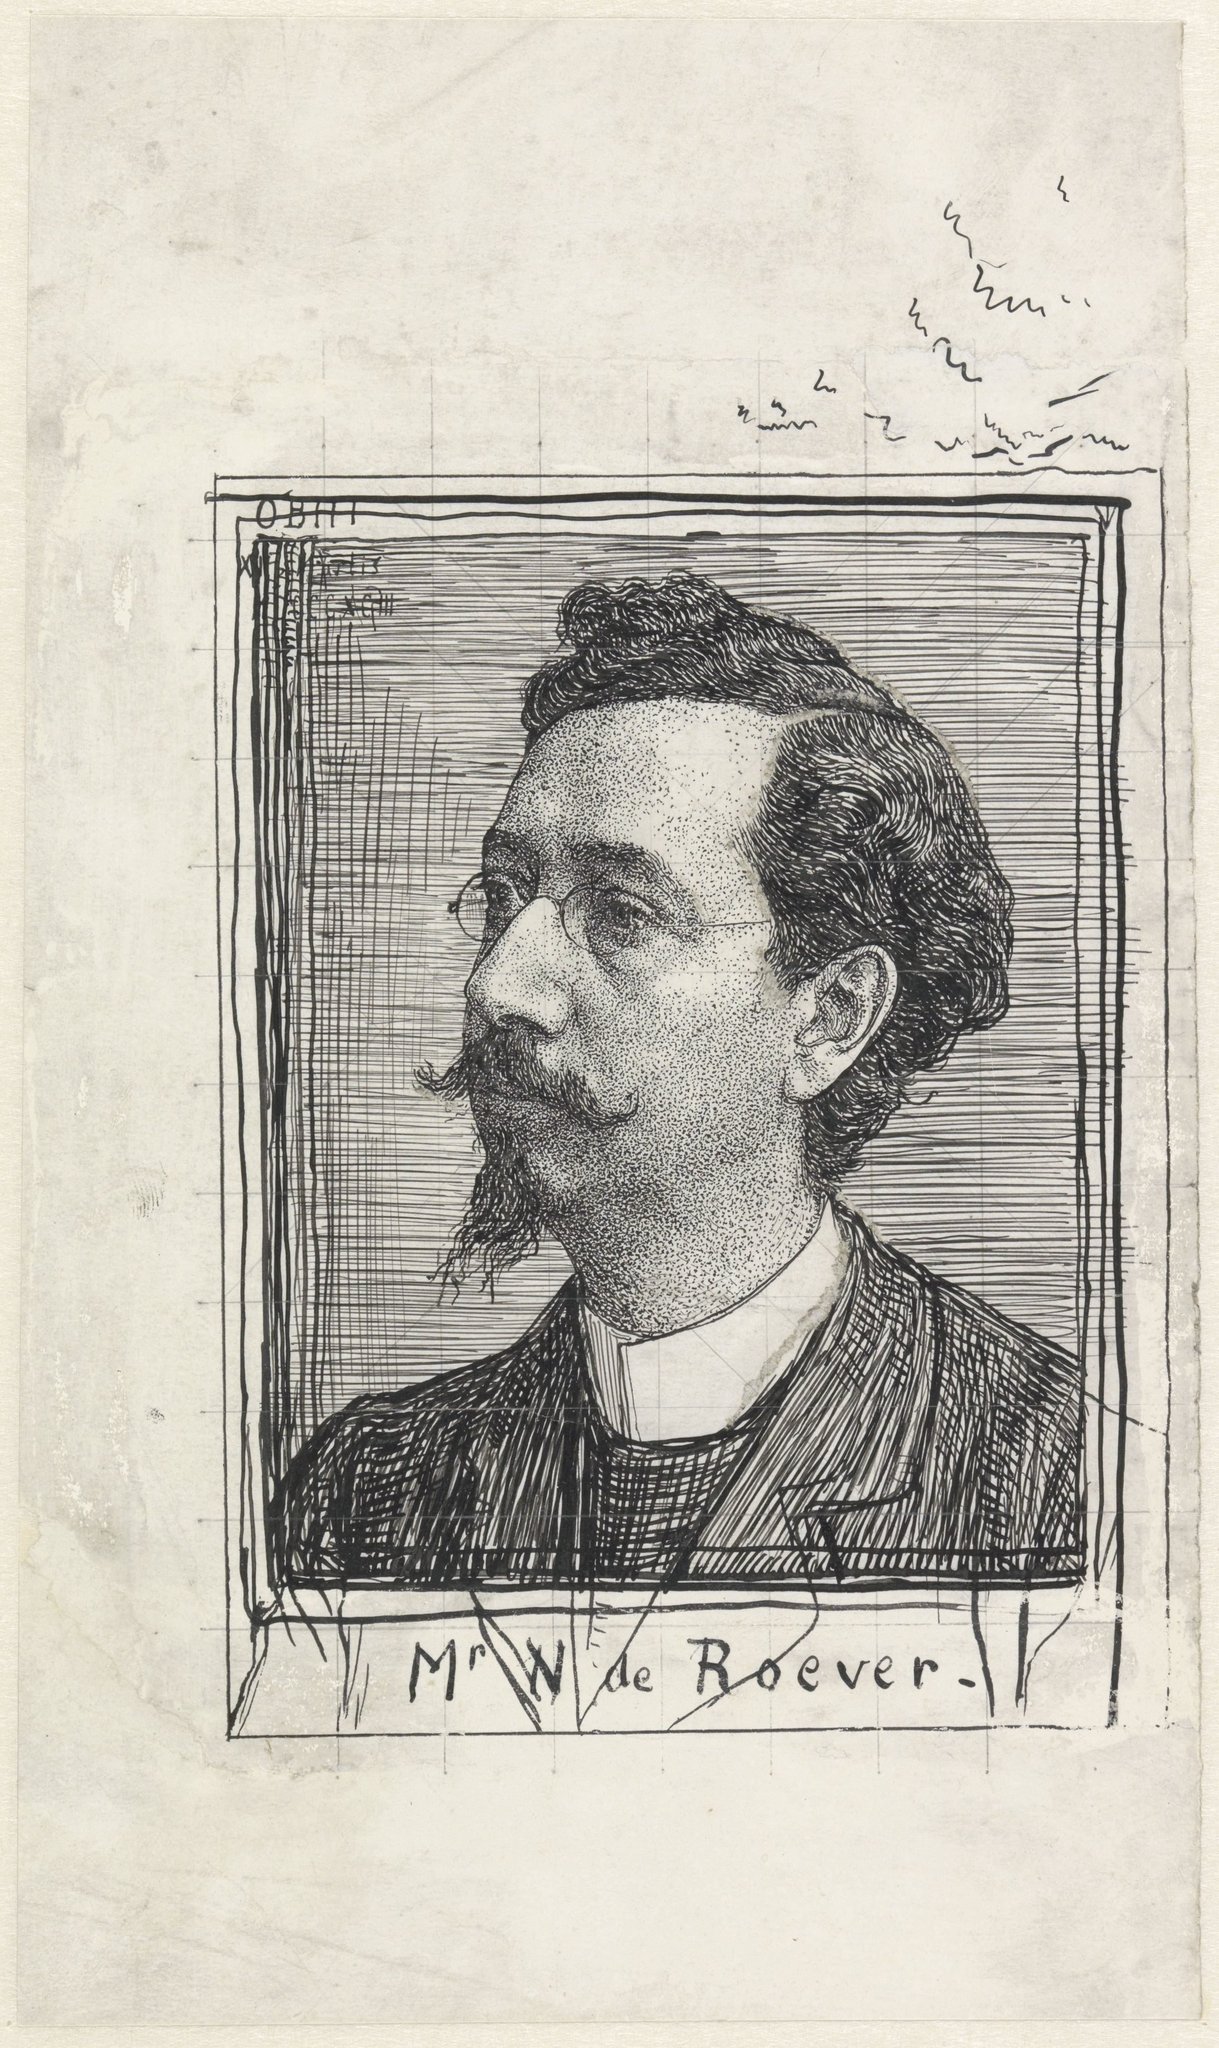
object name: drawing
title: Portret van Nicolaas de Roever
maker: jan veth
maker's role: designer, draughtsman, painter, print maker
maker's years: 1864-1925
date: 1893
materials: ink, paper, pencil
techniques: pen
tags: historical persons